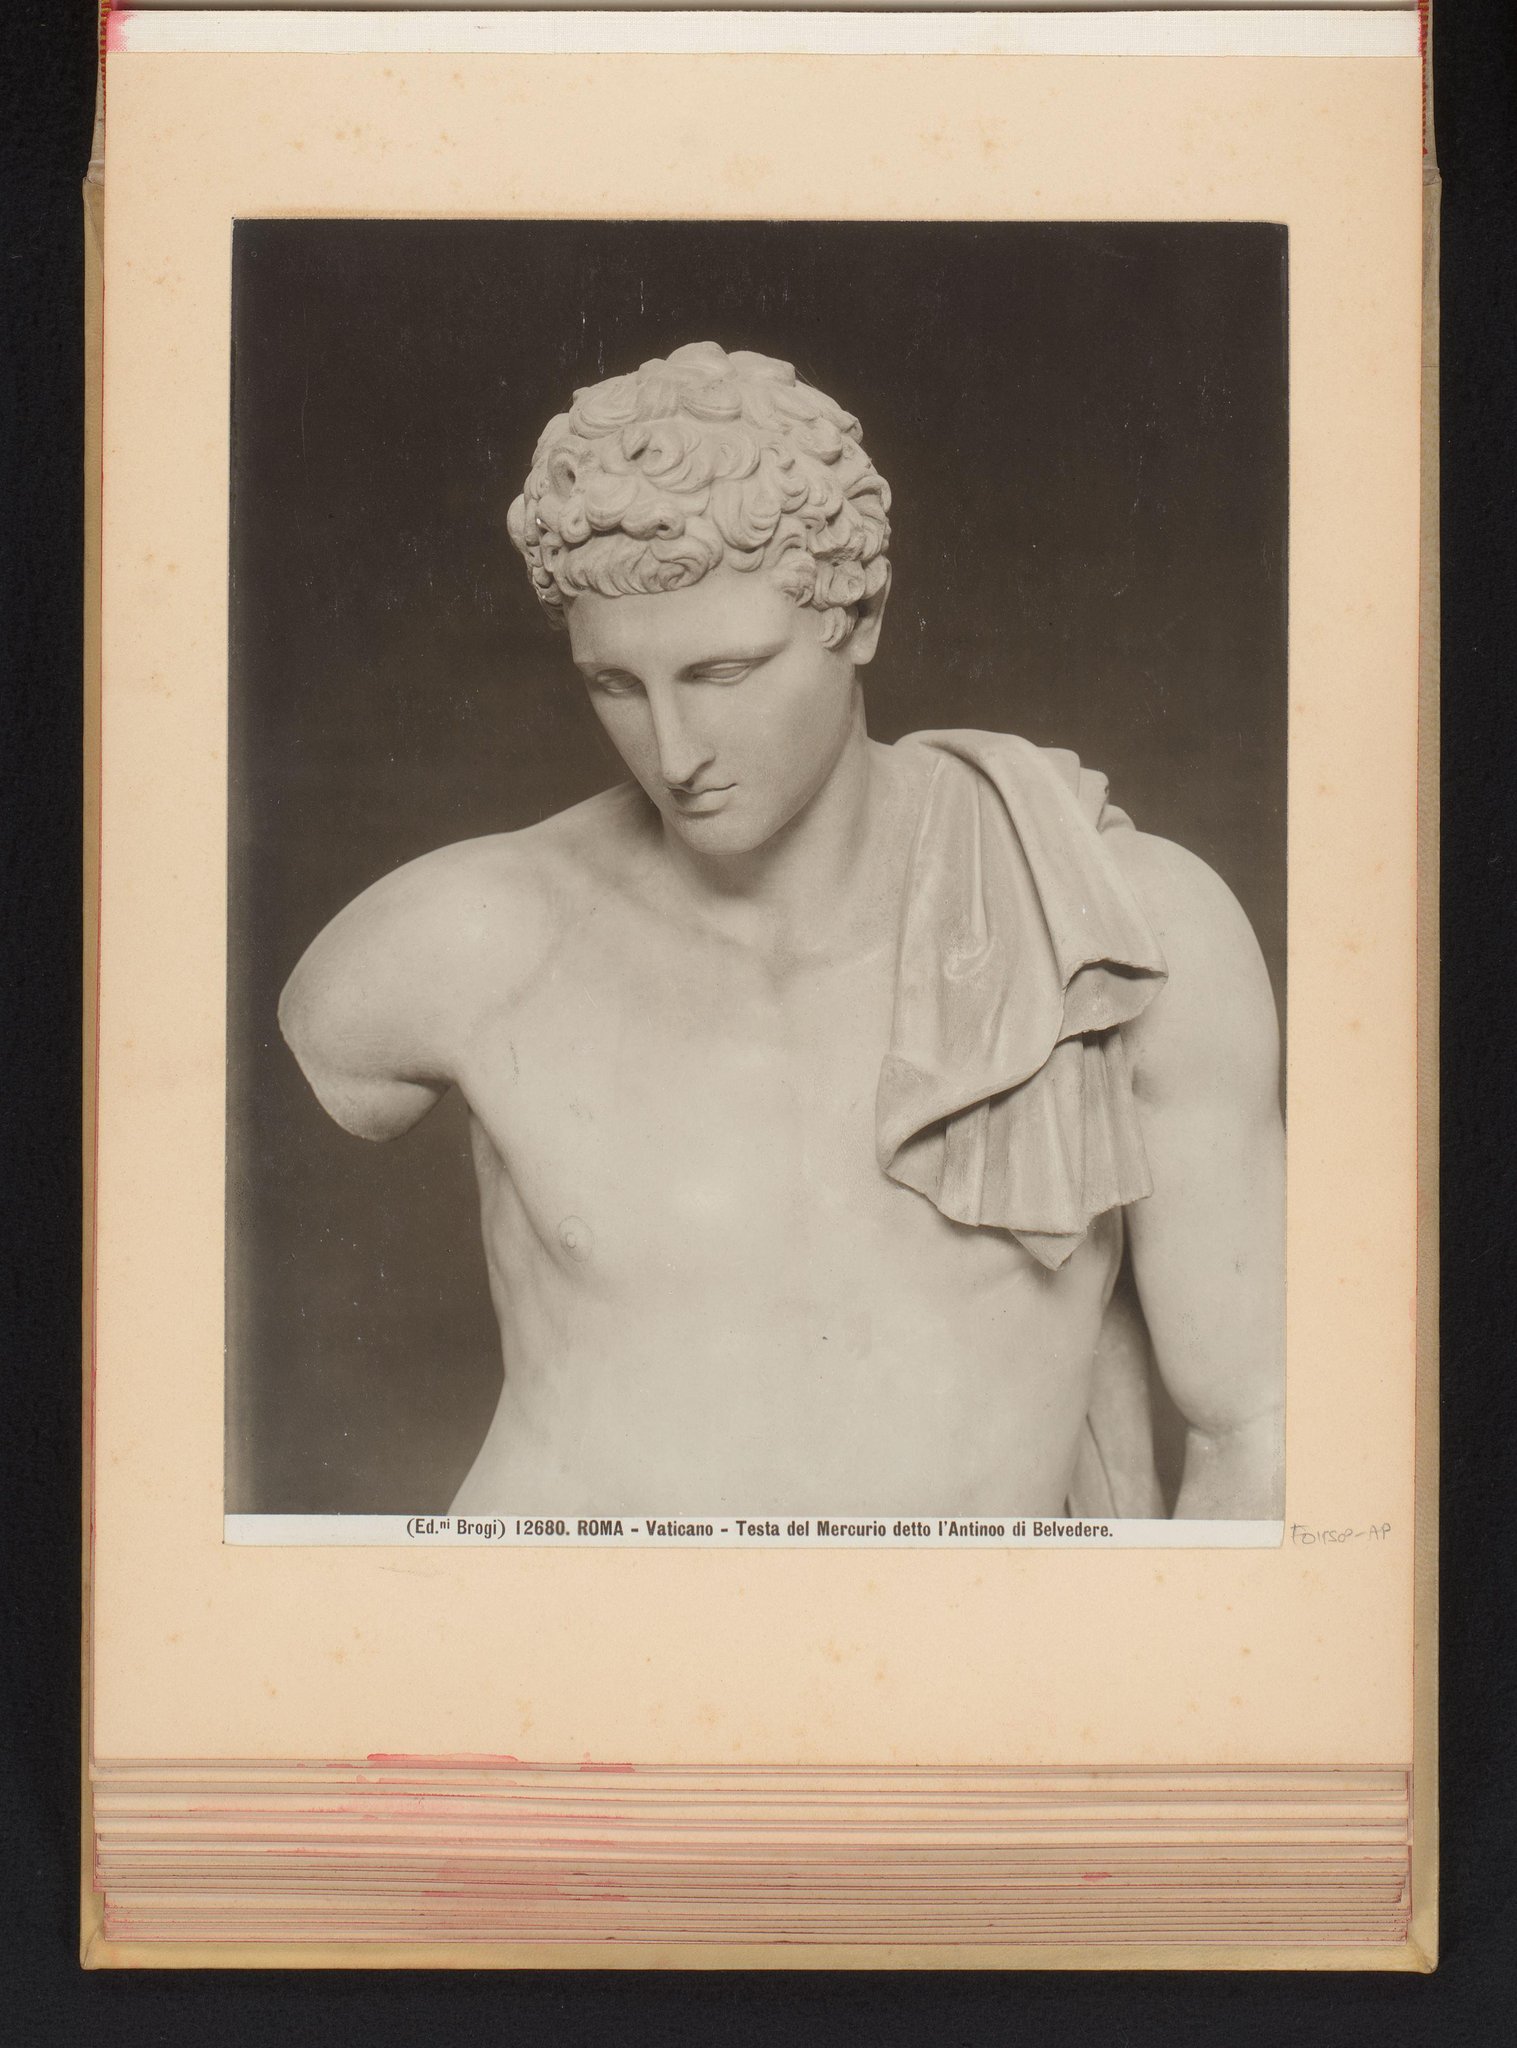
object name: photograph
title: Hoofd van de Hermes van Belvedère in de Vaticaanse Musea te Vaticaanstad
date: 1875-1907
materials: photographic support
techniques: gelatin silver print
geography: vatican museums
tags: (story of) mercury (hermes), sculpture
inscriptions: number: ‘12680’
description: Onderdeel van Fotoalbum met opnames van bezienswaardigheden en kunstwerken in Italië.